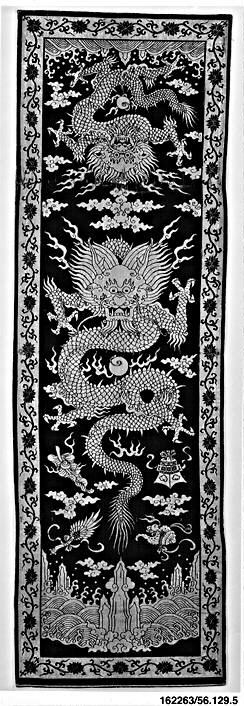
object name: chair strip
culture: chinese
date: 1701-1733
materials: metal thread, silk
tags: dragons